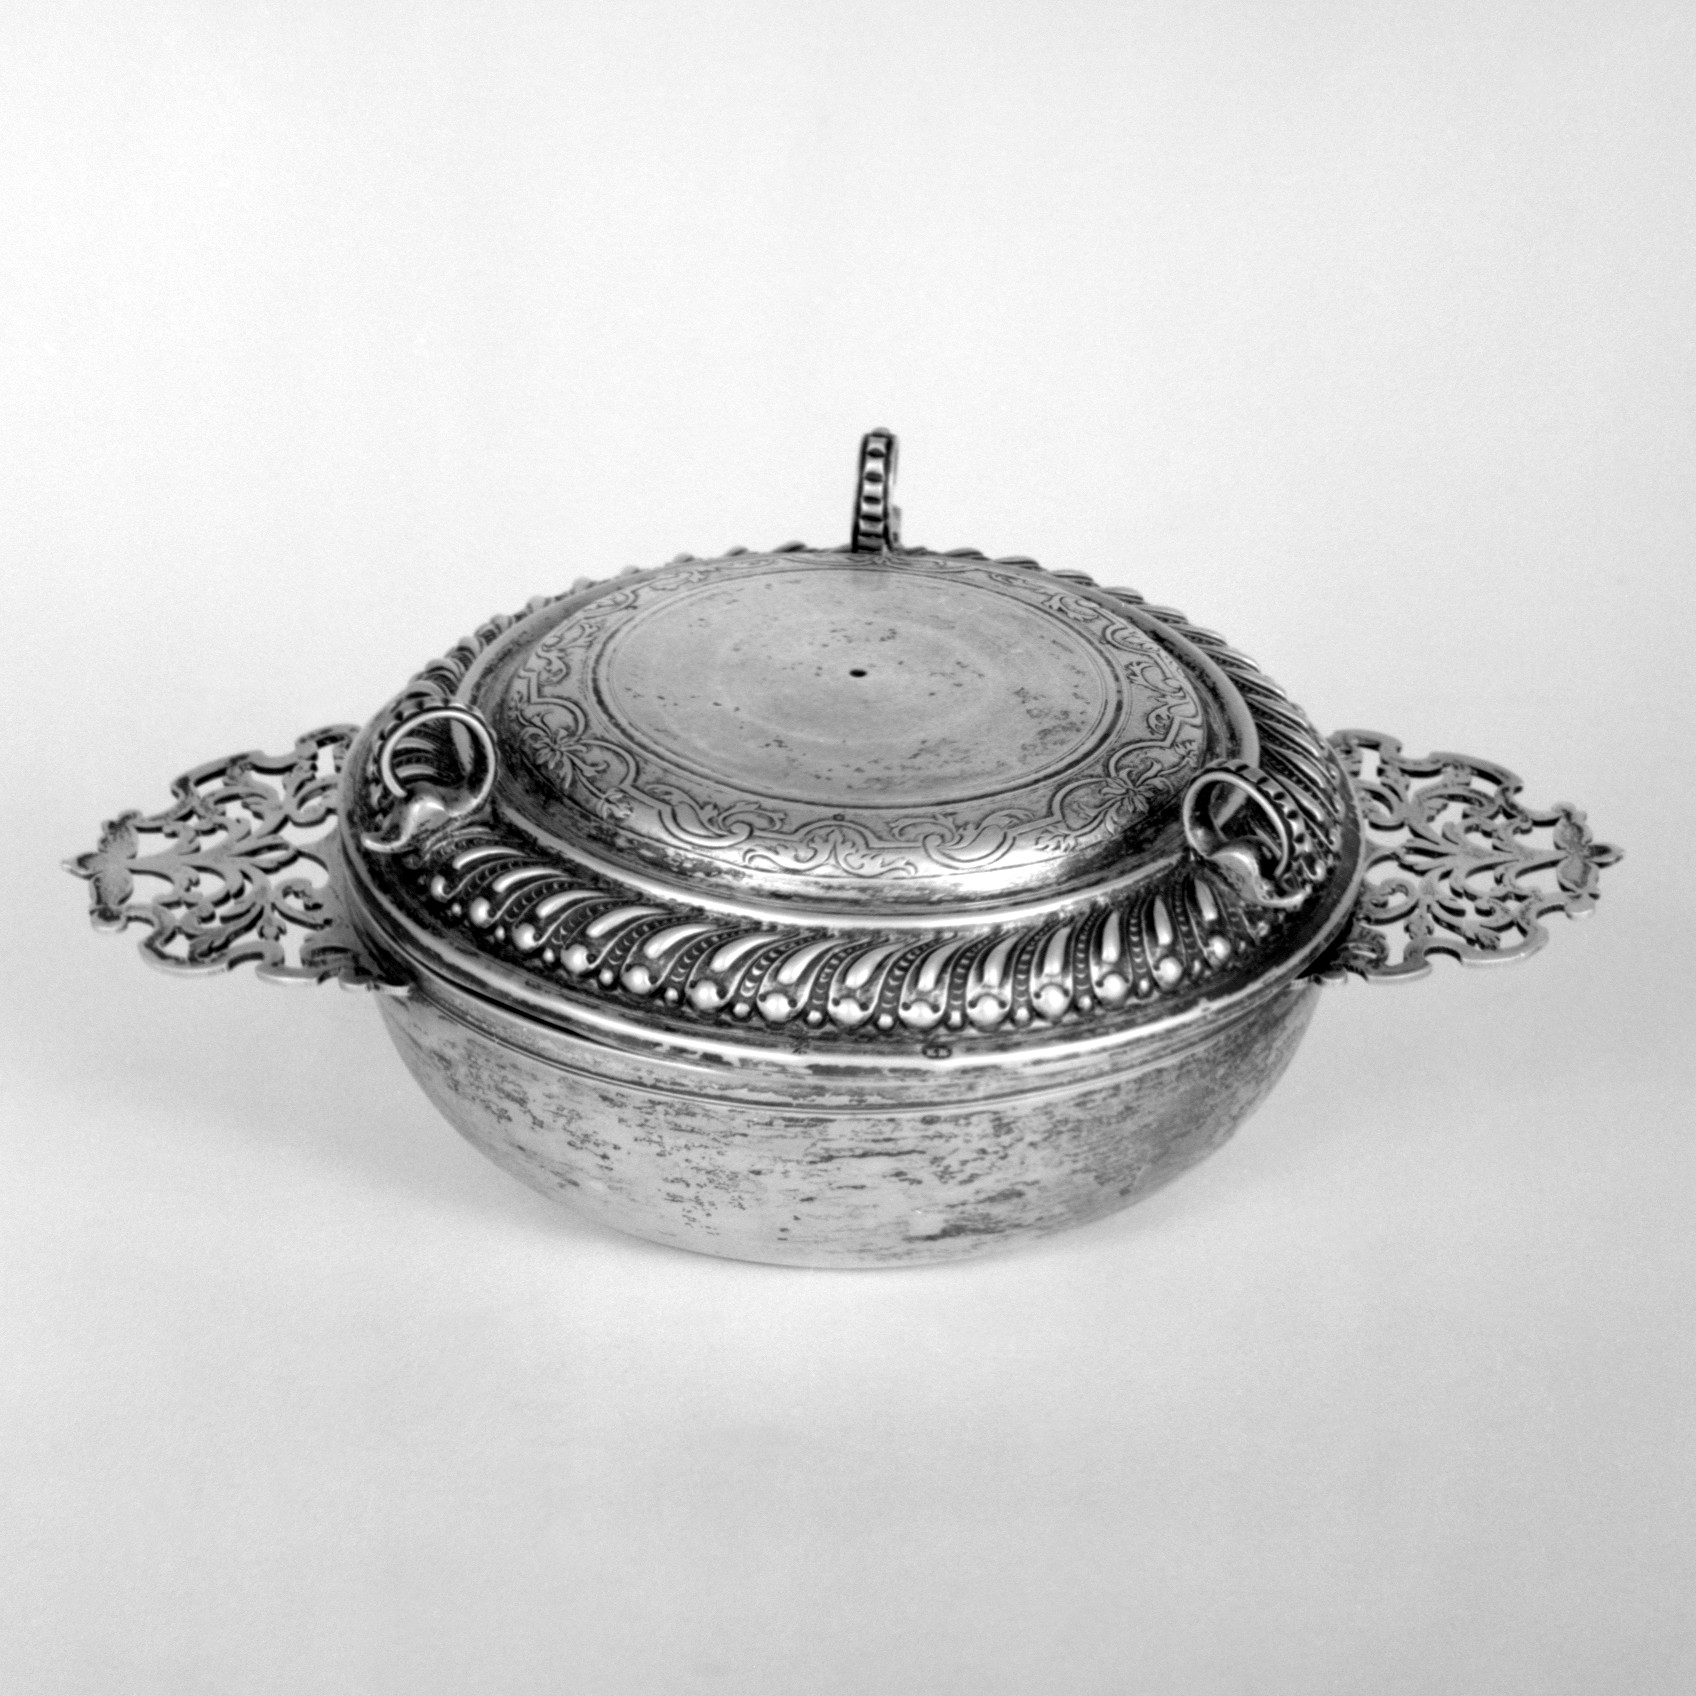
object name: écuelle with cover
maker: esaias busch iii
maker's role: maker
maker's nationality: german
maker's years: 1676-1759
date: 1714-1718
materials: silver